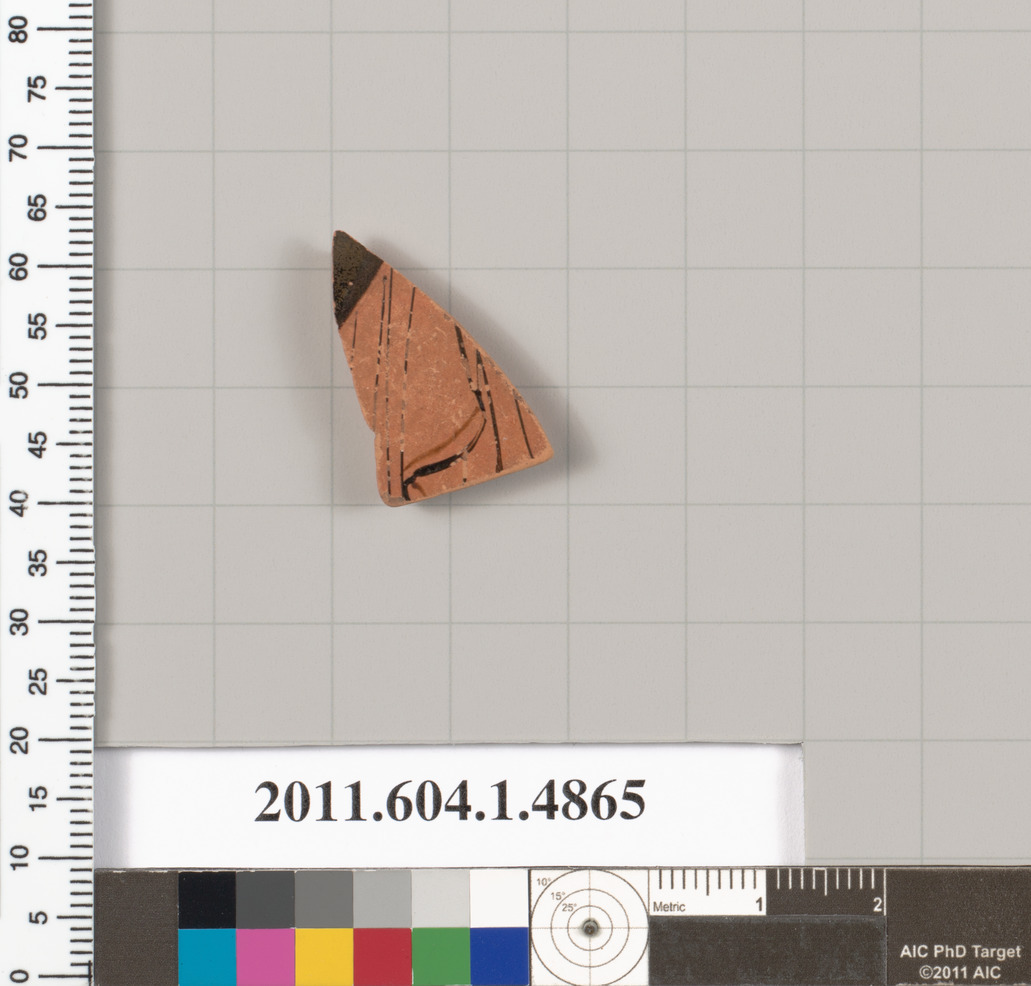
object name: kylix fragment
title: Terracotta fragment of a kylix (drinking cup)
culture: greek, attic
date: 475-451 BCE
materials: terracotta